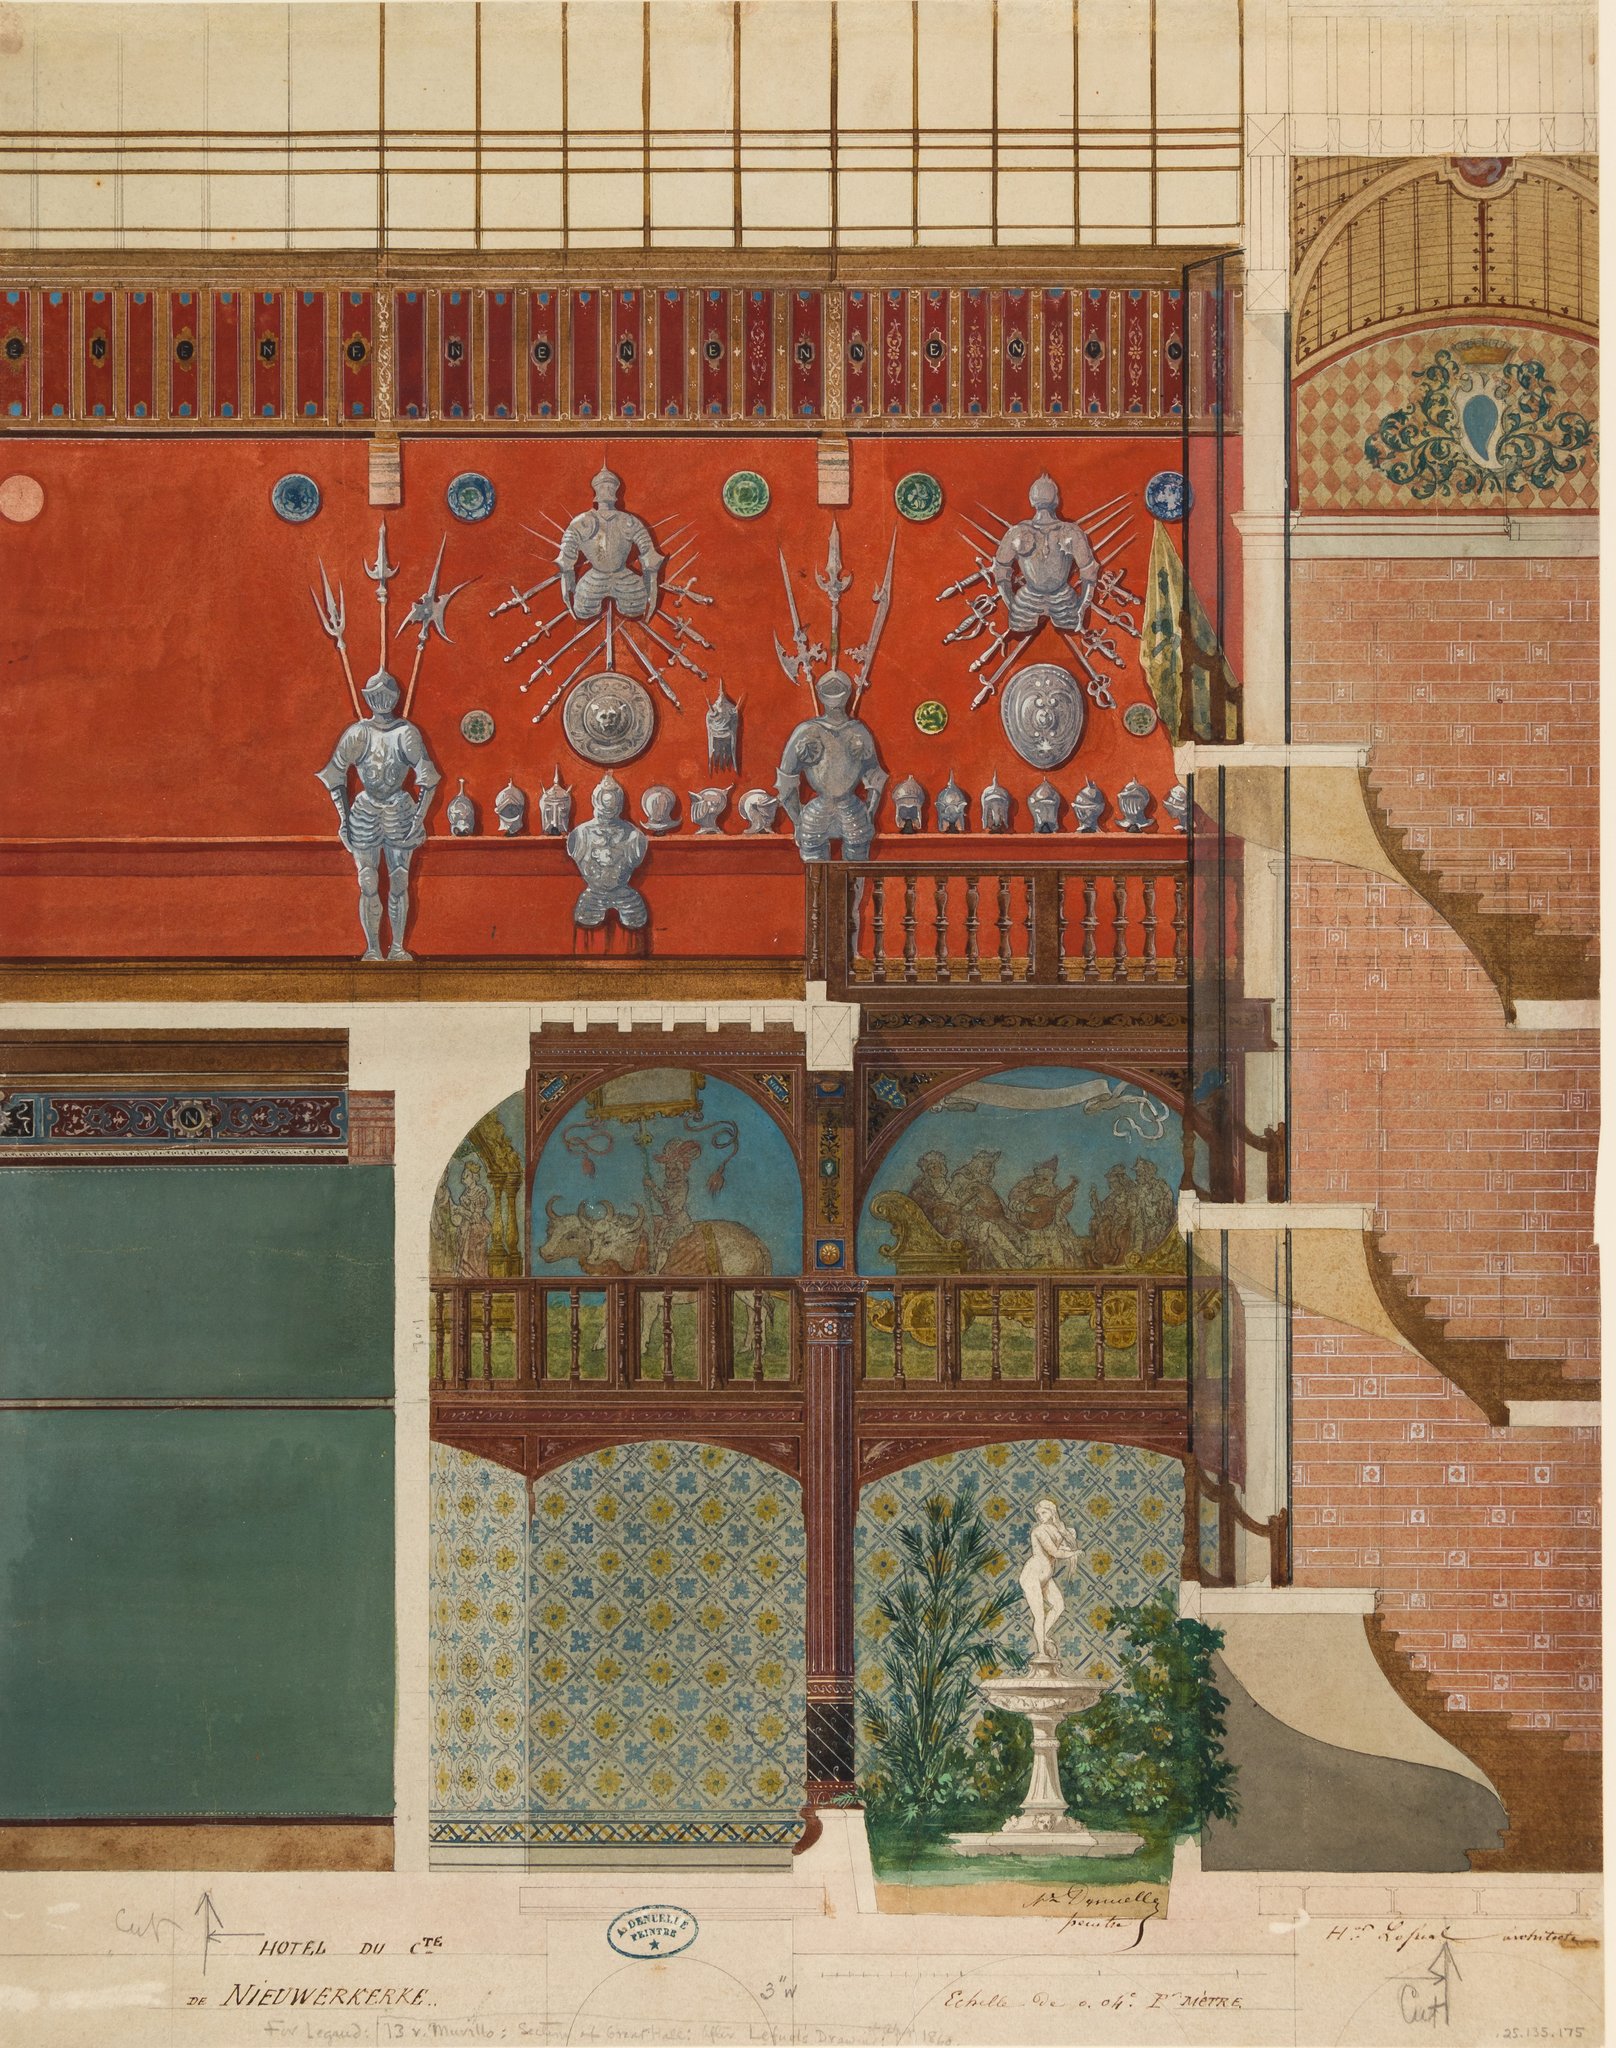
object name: drawing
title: Architectural Drawing of the Interior of the Comte de Nieuwerkerke's House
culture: french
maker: hector-martin lefuel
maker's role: artist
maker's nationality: french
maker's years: 1810-1880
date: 1870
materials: paper, watercolor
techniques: pen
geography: france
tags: architecture,interiors,armor